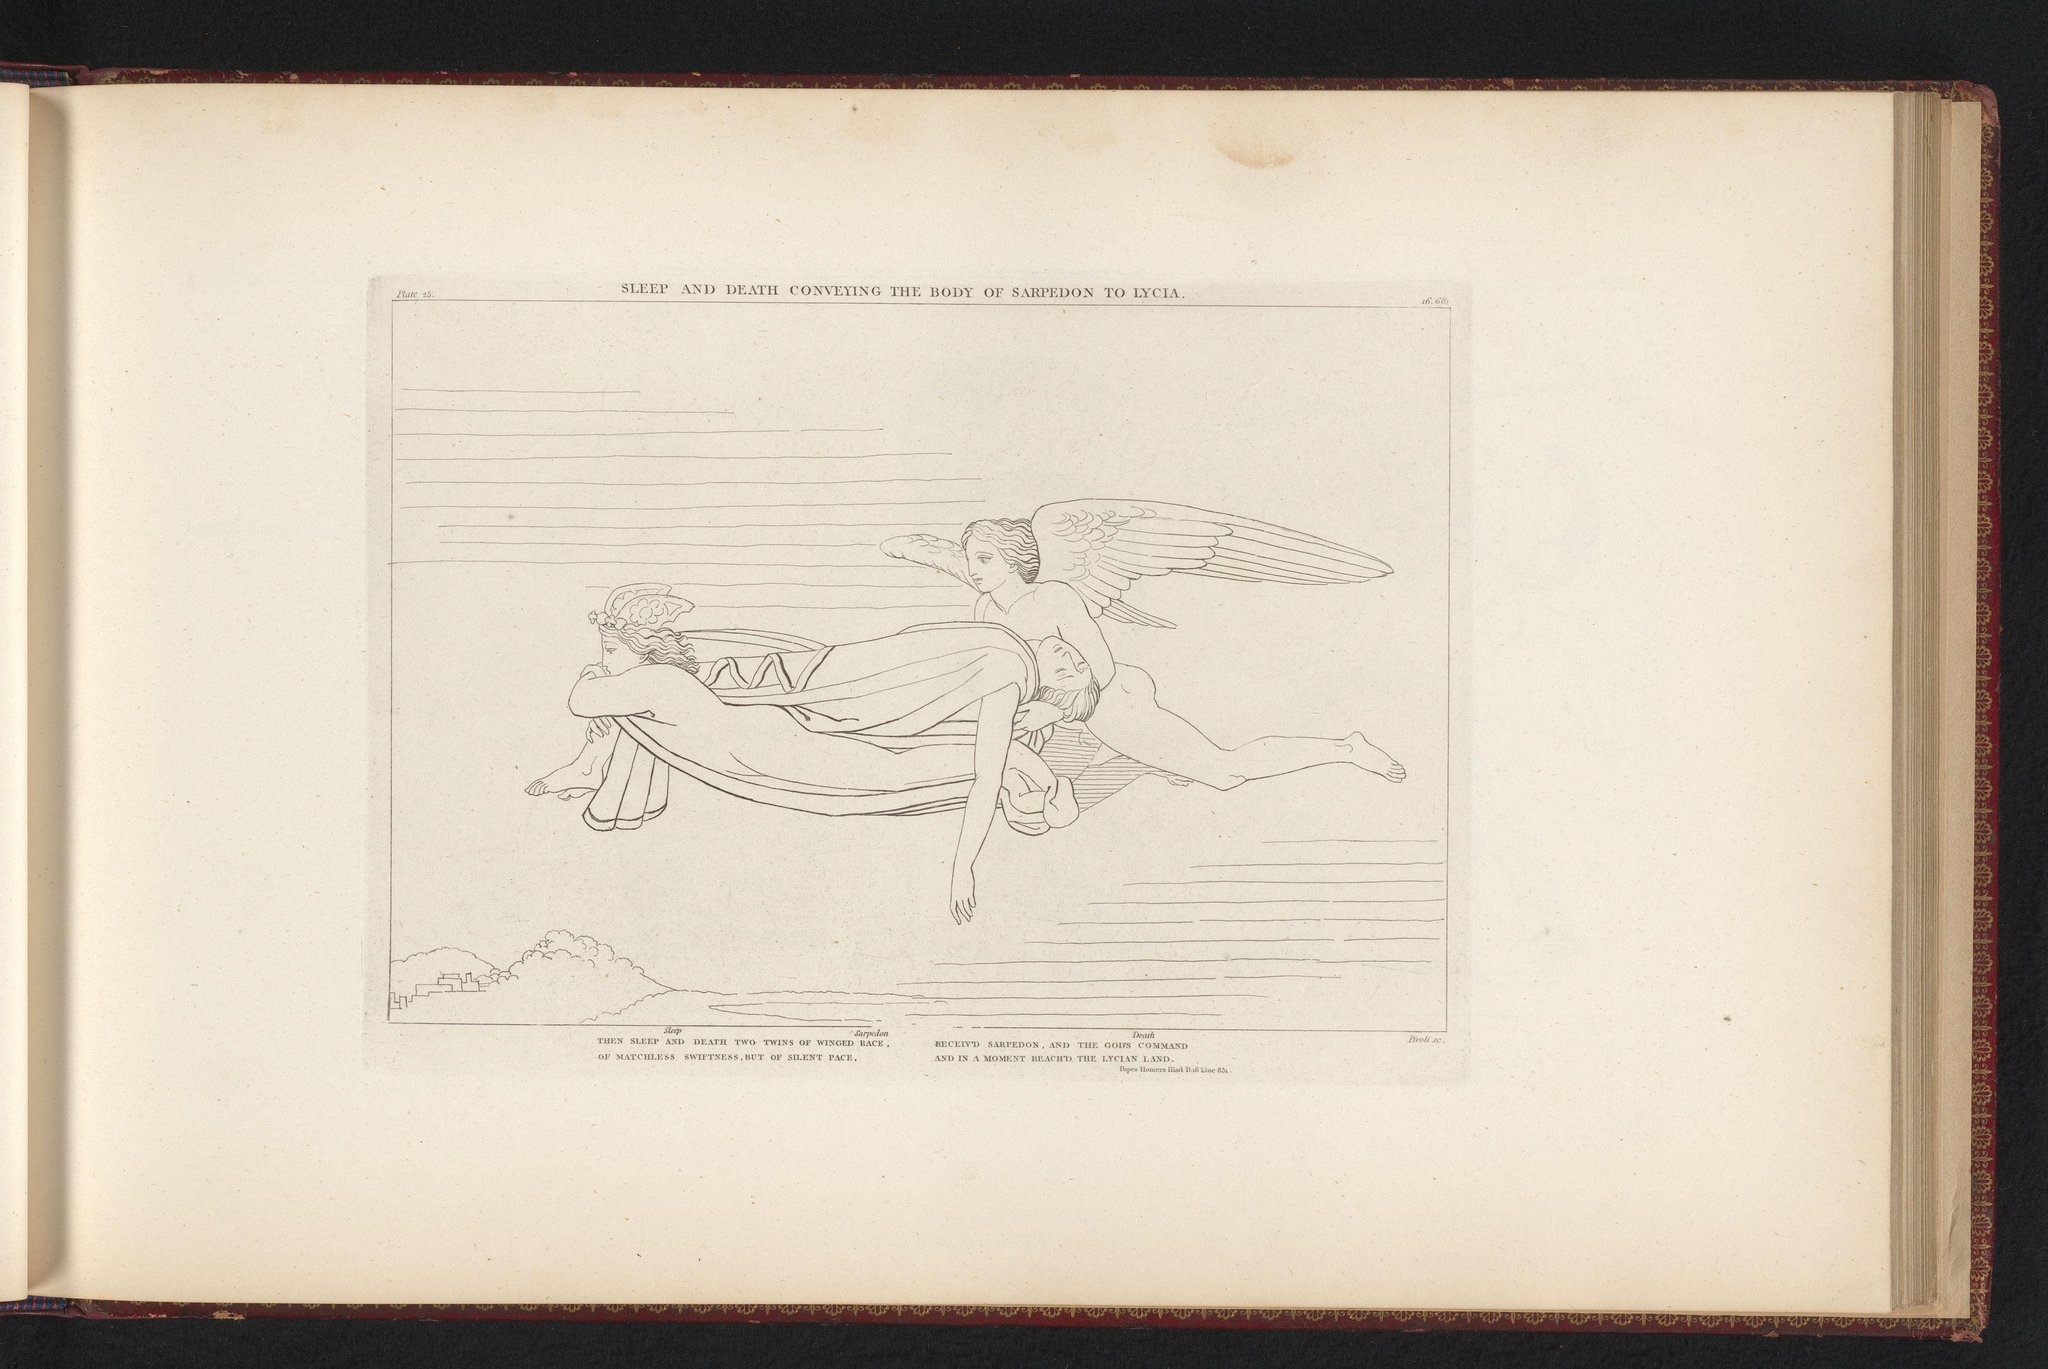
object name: album leaf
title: Sleep and Death conveying the body of Sarpedon to Lycia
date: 1805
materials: paper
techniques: etching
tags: the body of sarpedon is carried through the air by hypnos and thanatos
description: Prent maakt onderdeel uit van een serie met 39 prenten over de Ilias, geschreven door Homerus.